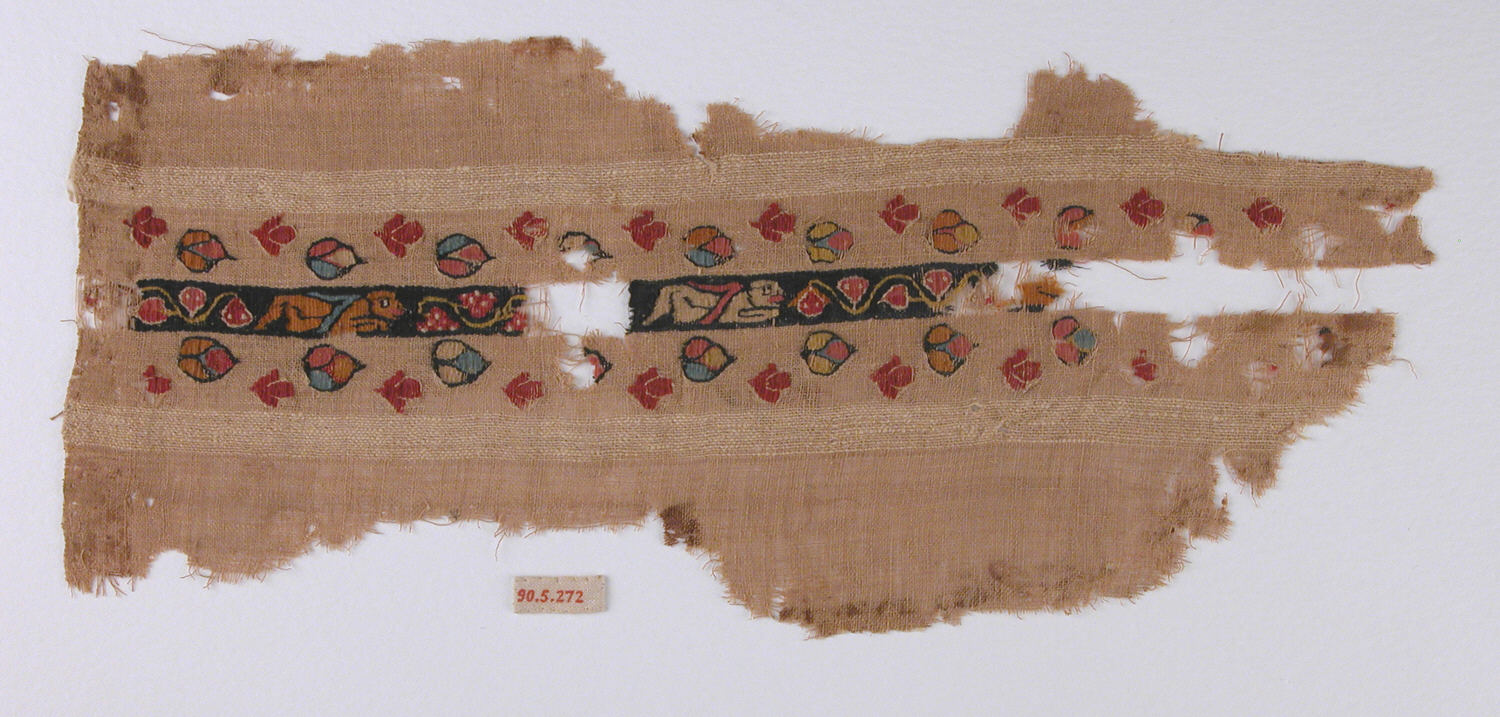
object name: textile fragment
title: Fragment of a Tunic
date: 401-500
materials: linen, wool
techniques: weave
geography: egypt